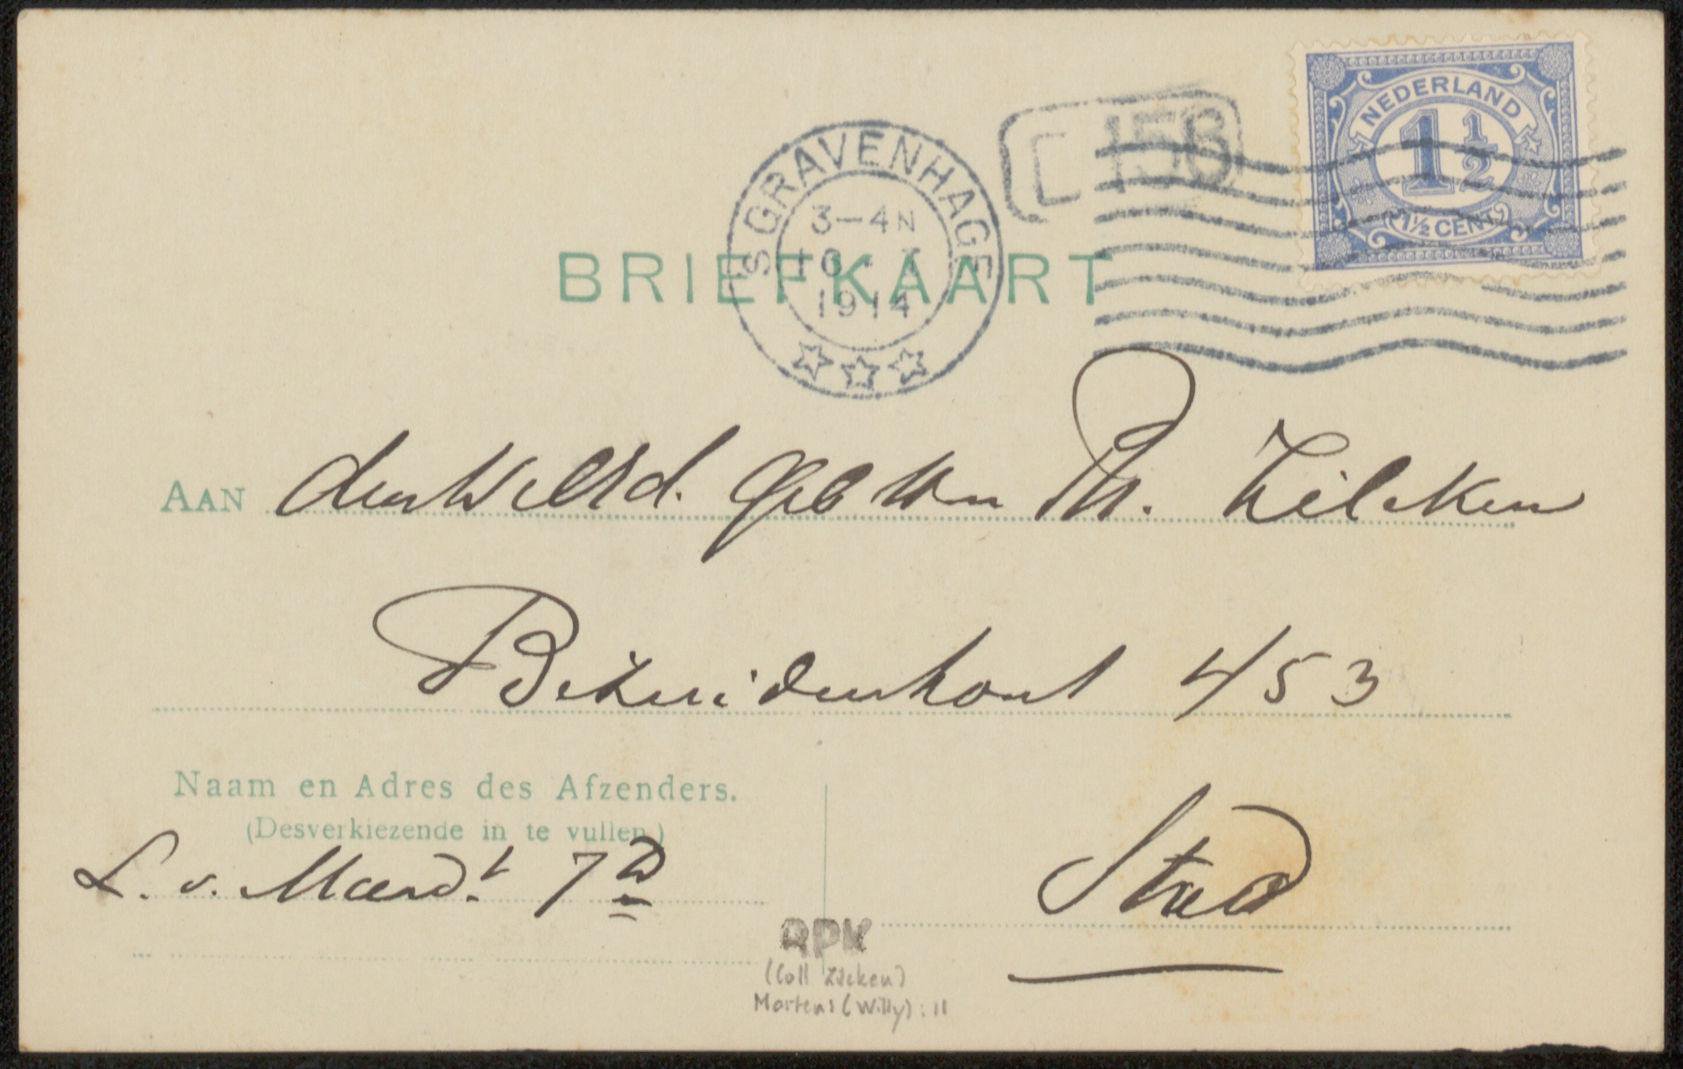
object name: postcard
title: Briefkaart aan Philip Zilcken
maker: willy martens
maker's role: painter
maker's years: 1856-1927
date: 1914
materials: cardboard, ink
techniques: pen, writing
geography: the hague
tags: the hague, painter, draughtsman, philip zilcken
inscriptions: collector's mark: ‘RPK’